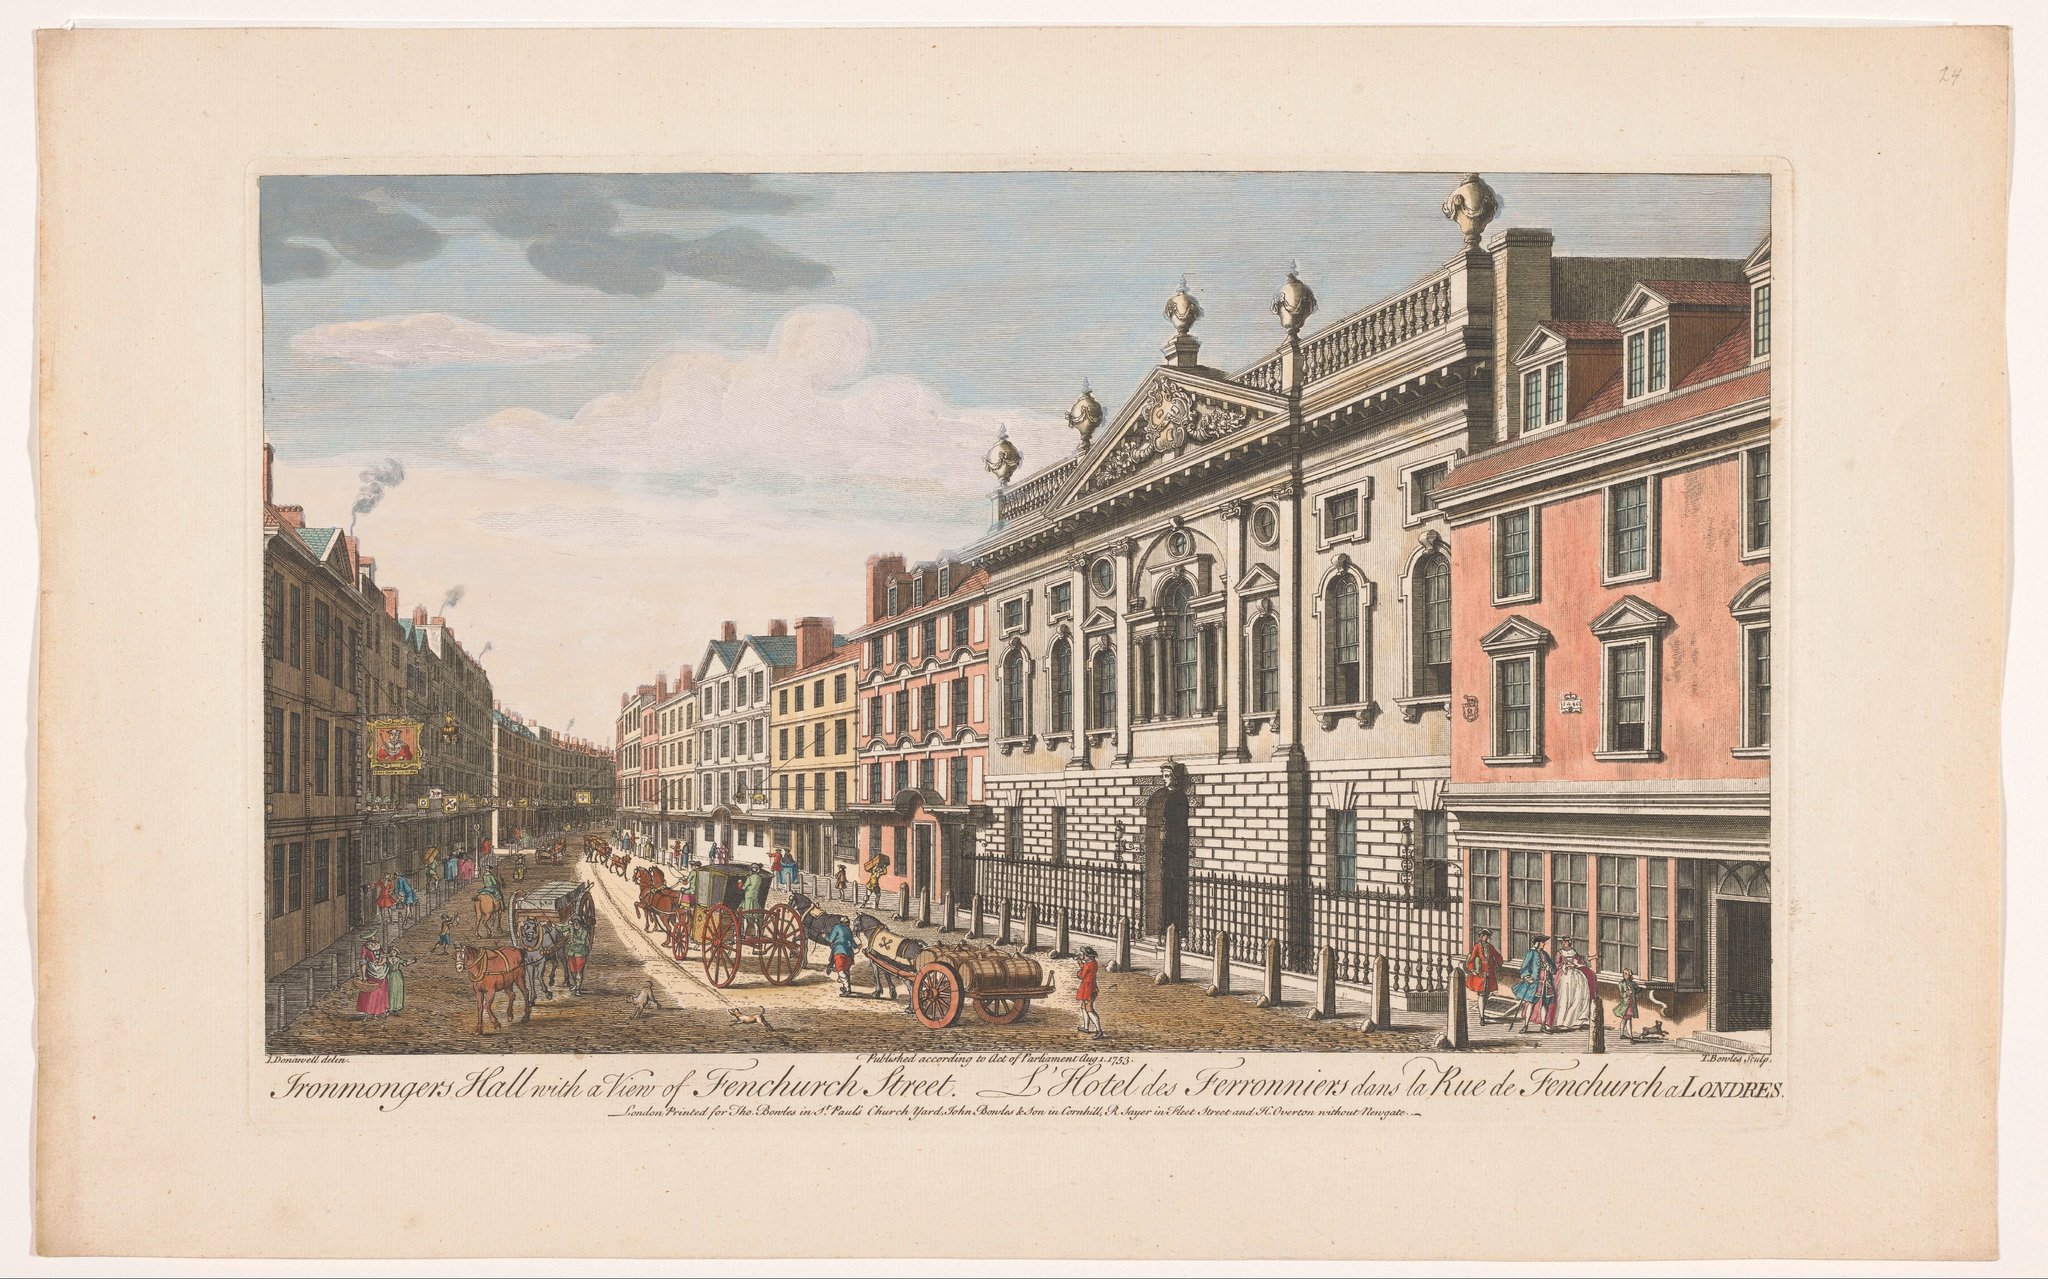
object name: print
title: Ironmongers Hall with a view of Fenchurch Street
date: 1753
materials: paper, watercolor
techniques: brush, etching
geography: london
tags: minerals and metals: iron, civic architecture; edifices; dwellings, street (+ city(-scape) with figures, staffage)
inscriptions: watermark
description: De serie “Londen” bevat 52 prenten met de nummers 1-52, waarvan dit nummer 24 is.